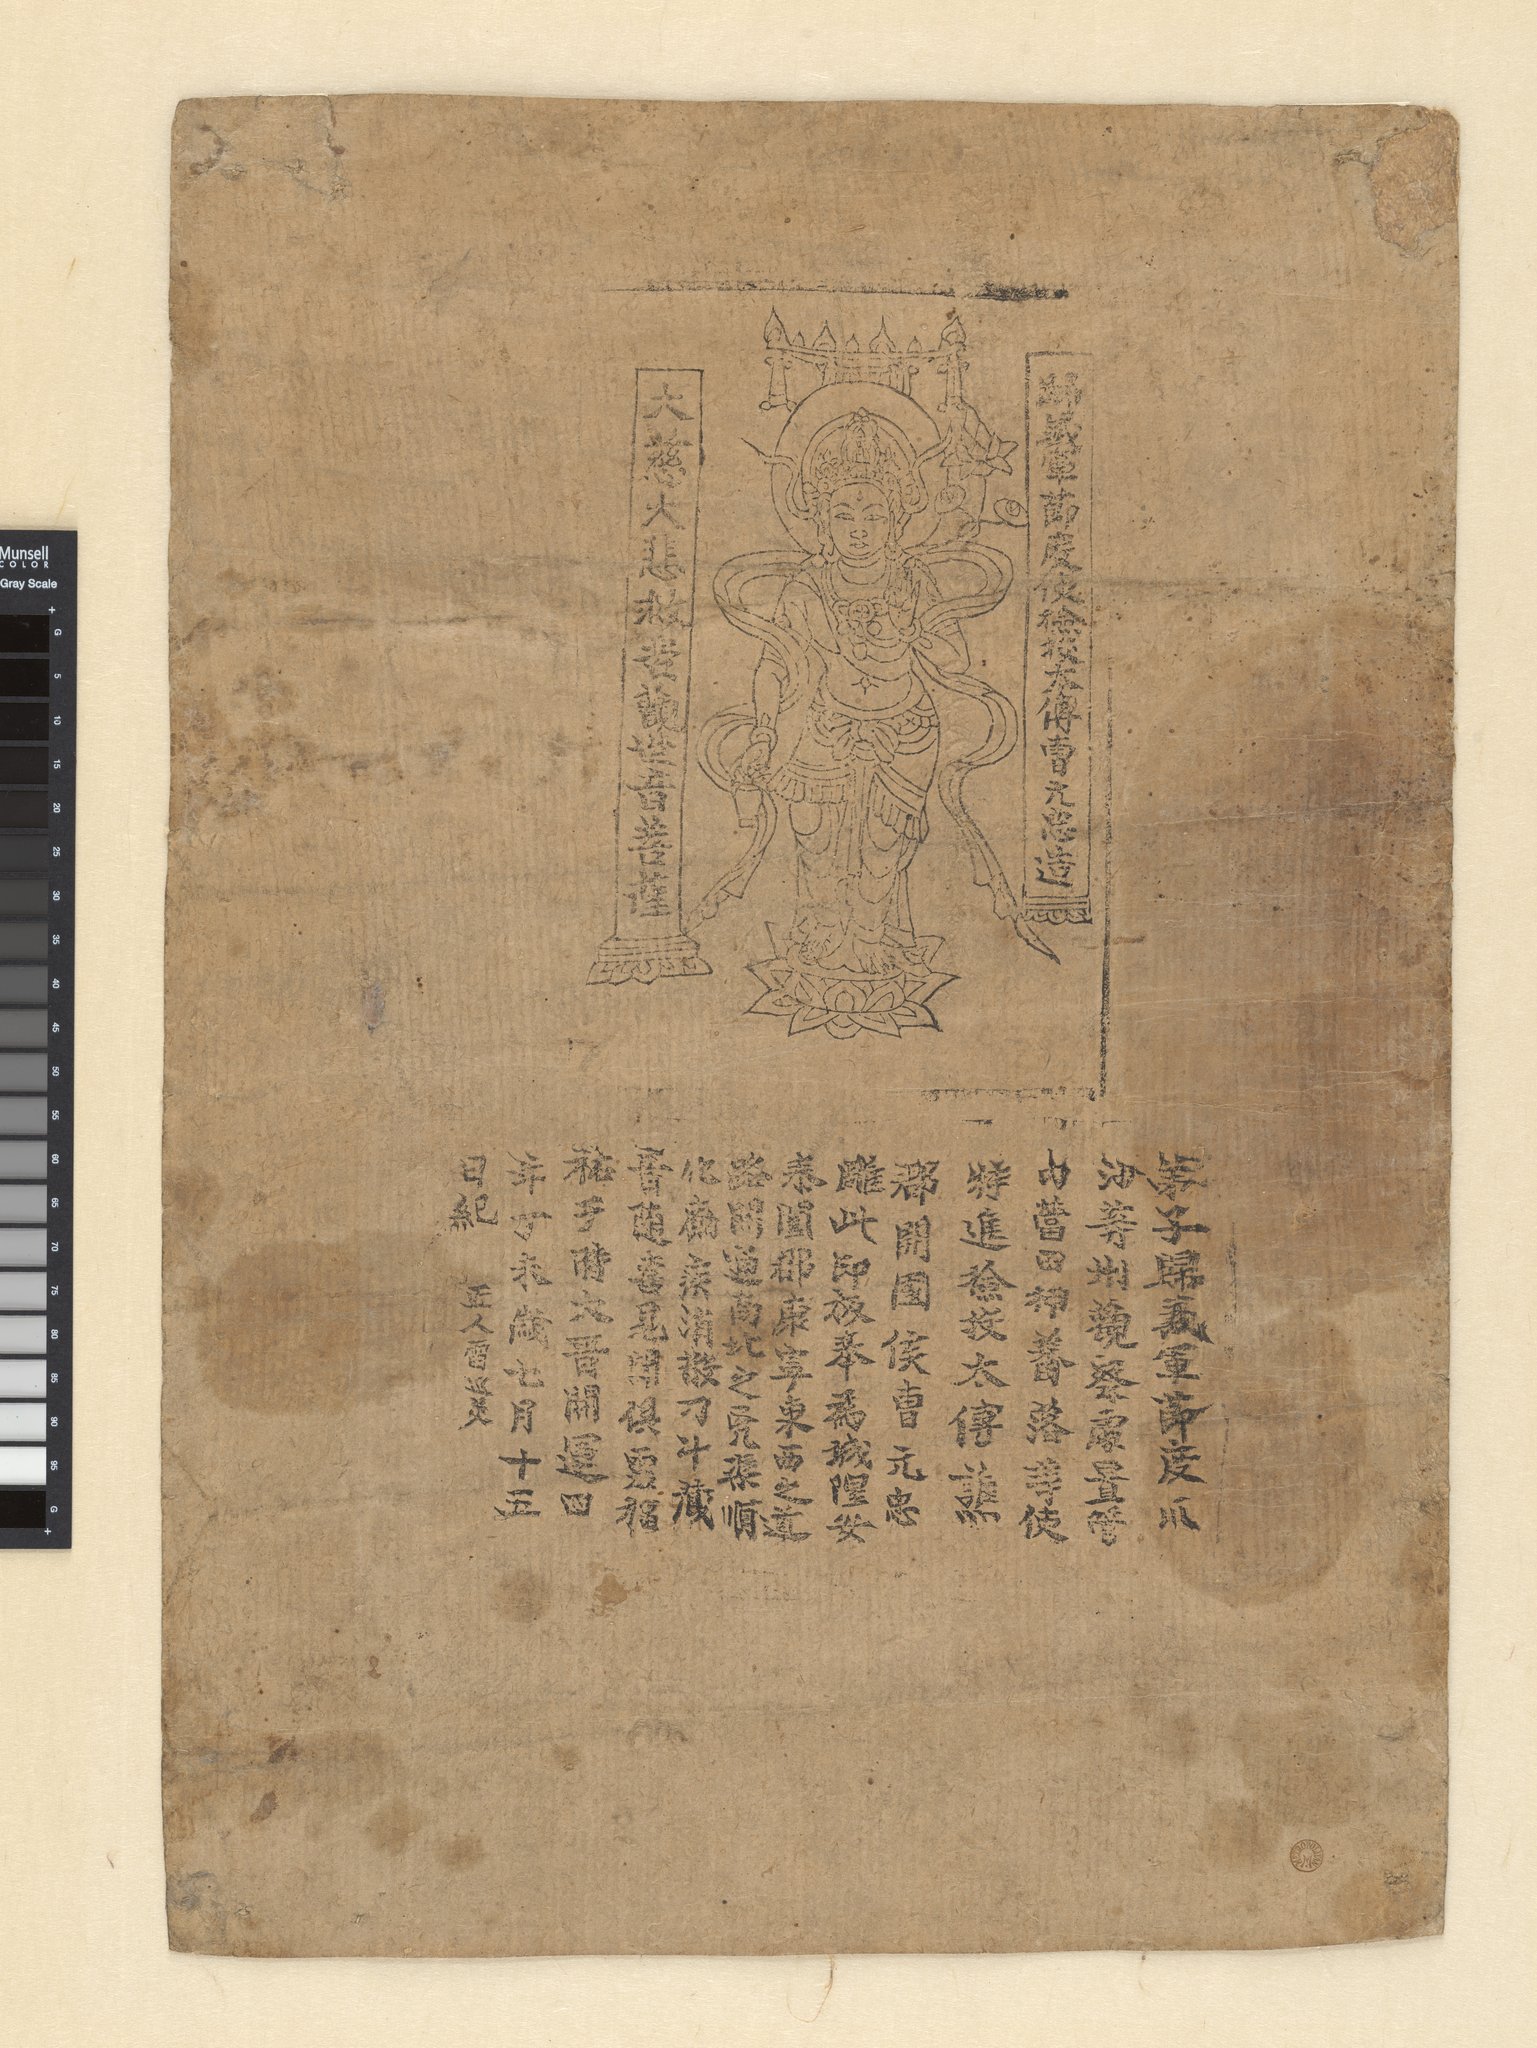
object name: print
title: The Greatly Merciful, Greatly Compassionate Rescuer from Suffering, Bodhisattva Guanyin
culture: chinese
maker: lei yanmei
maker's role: artist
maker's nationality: chinese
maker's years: 900-999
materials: ink, paper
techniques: woodblock print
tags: buddhism,avalokiteshvara,bodhisattvas